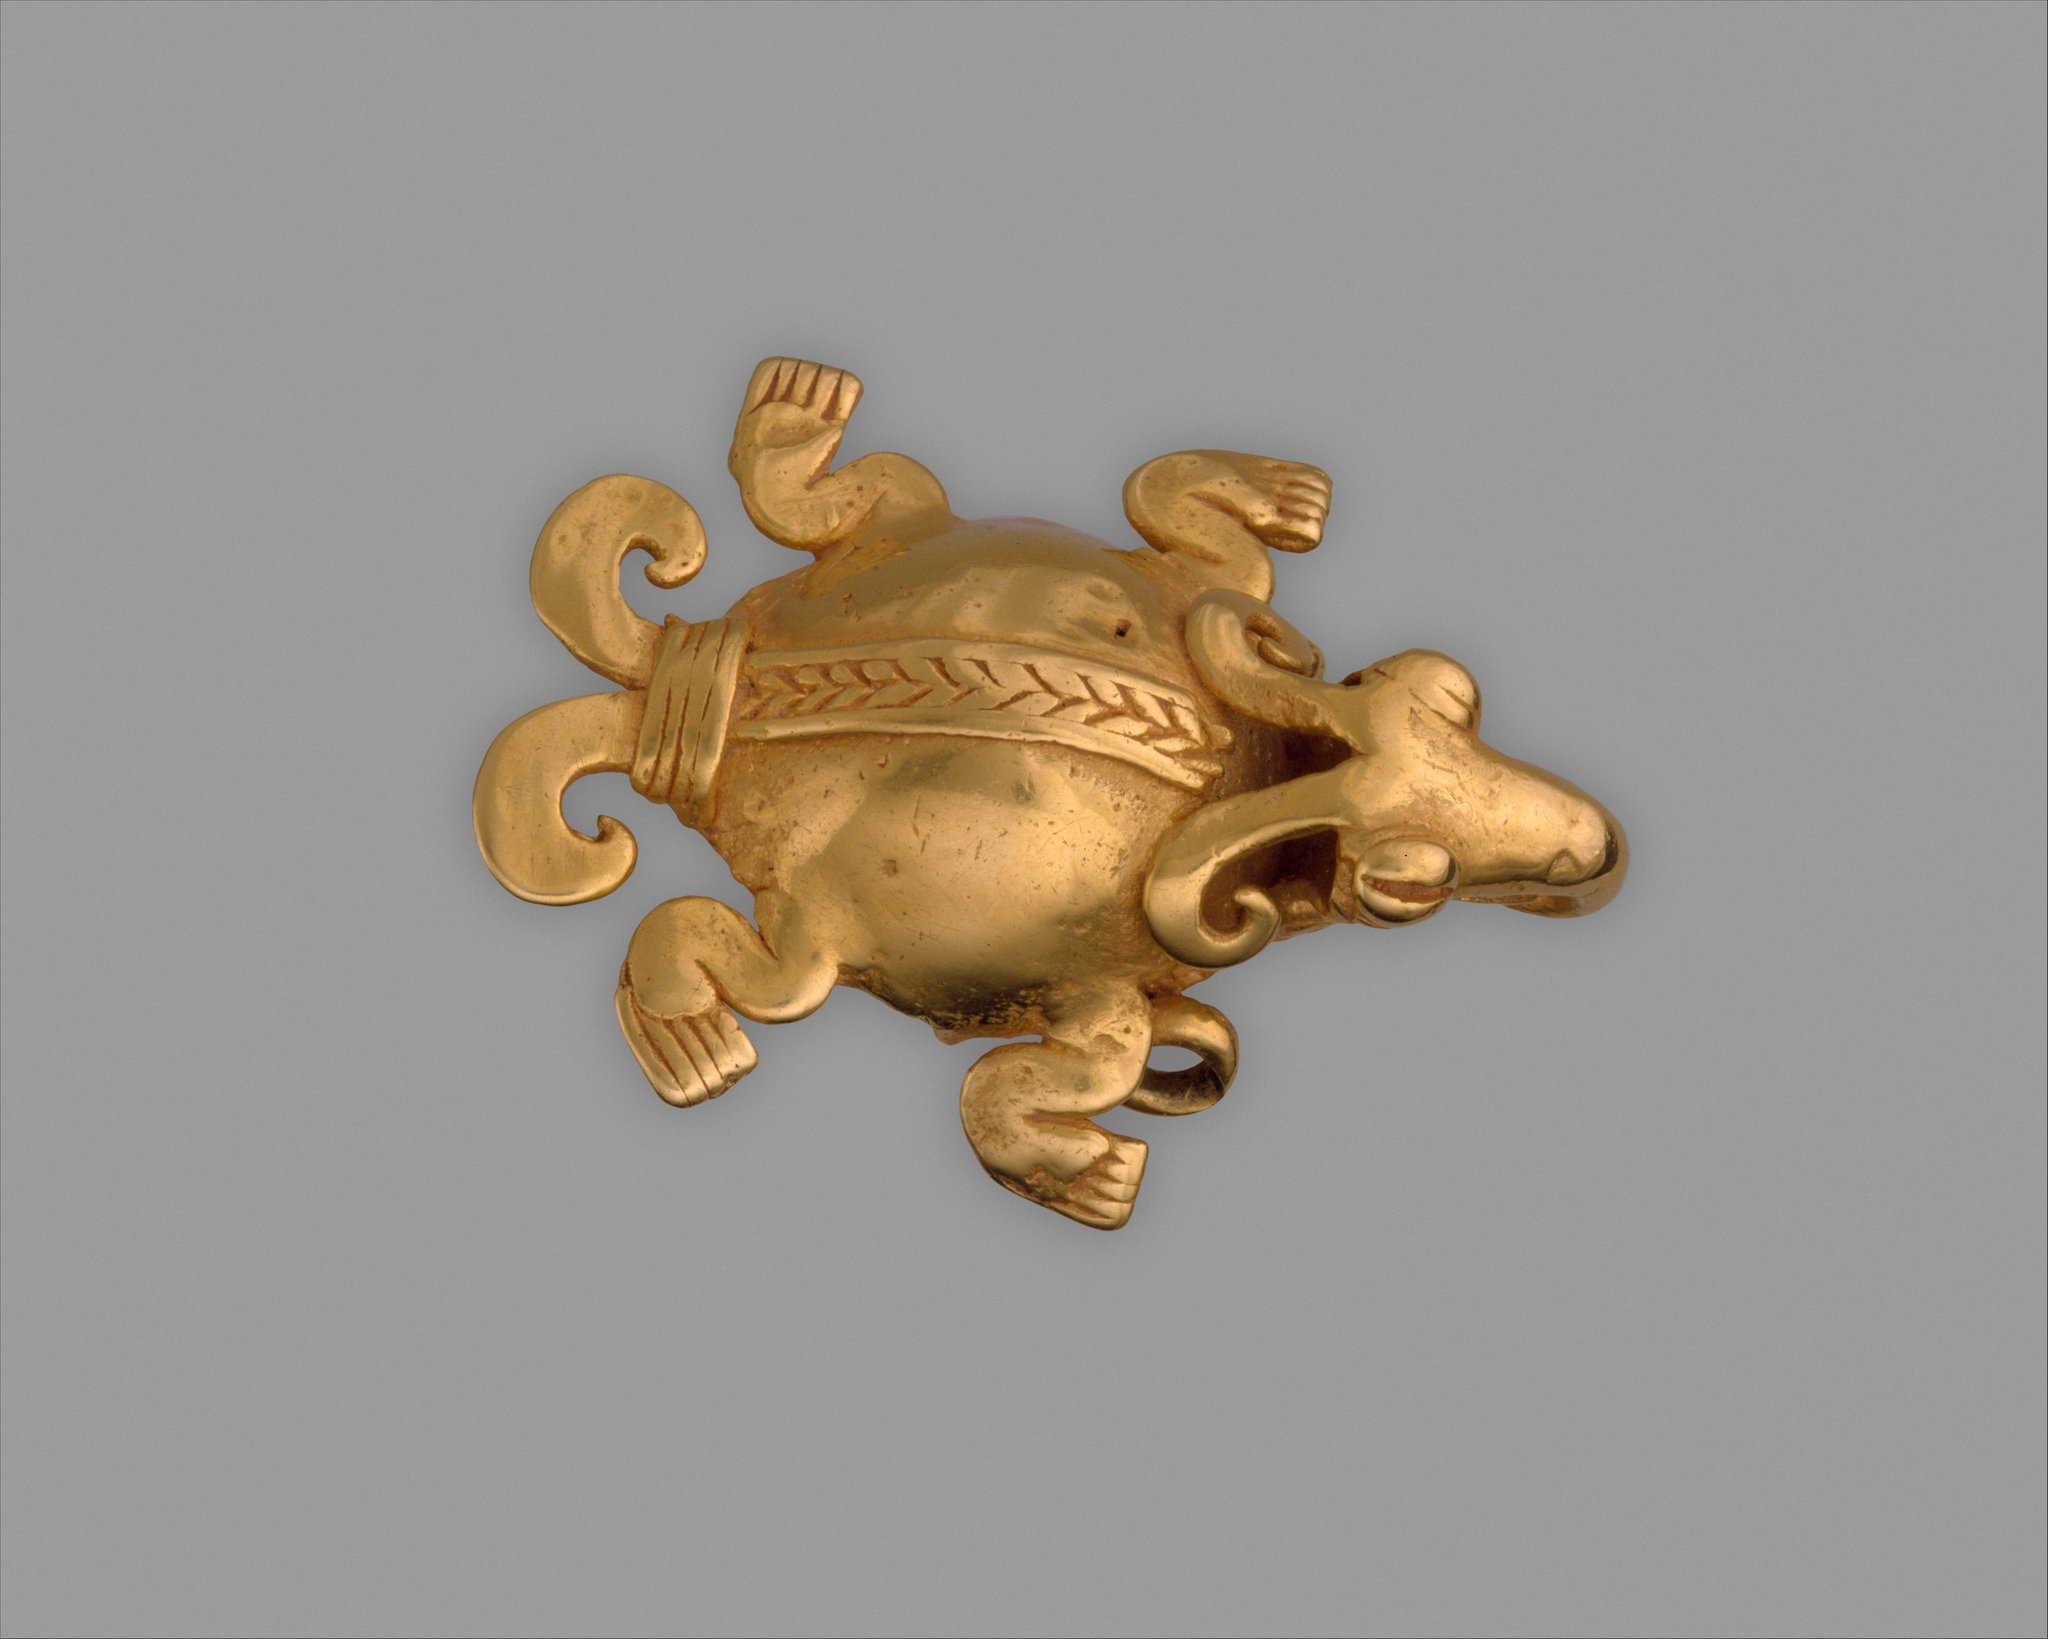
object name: pendant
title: Turtle Pendant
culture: veraguas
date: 1001-1600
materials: gold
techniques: casting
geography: panama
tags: turtles